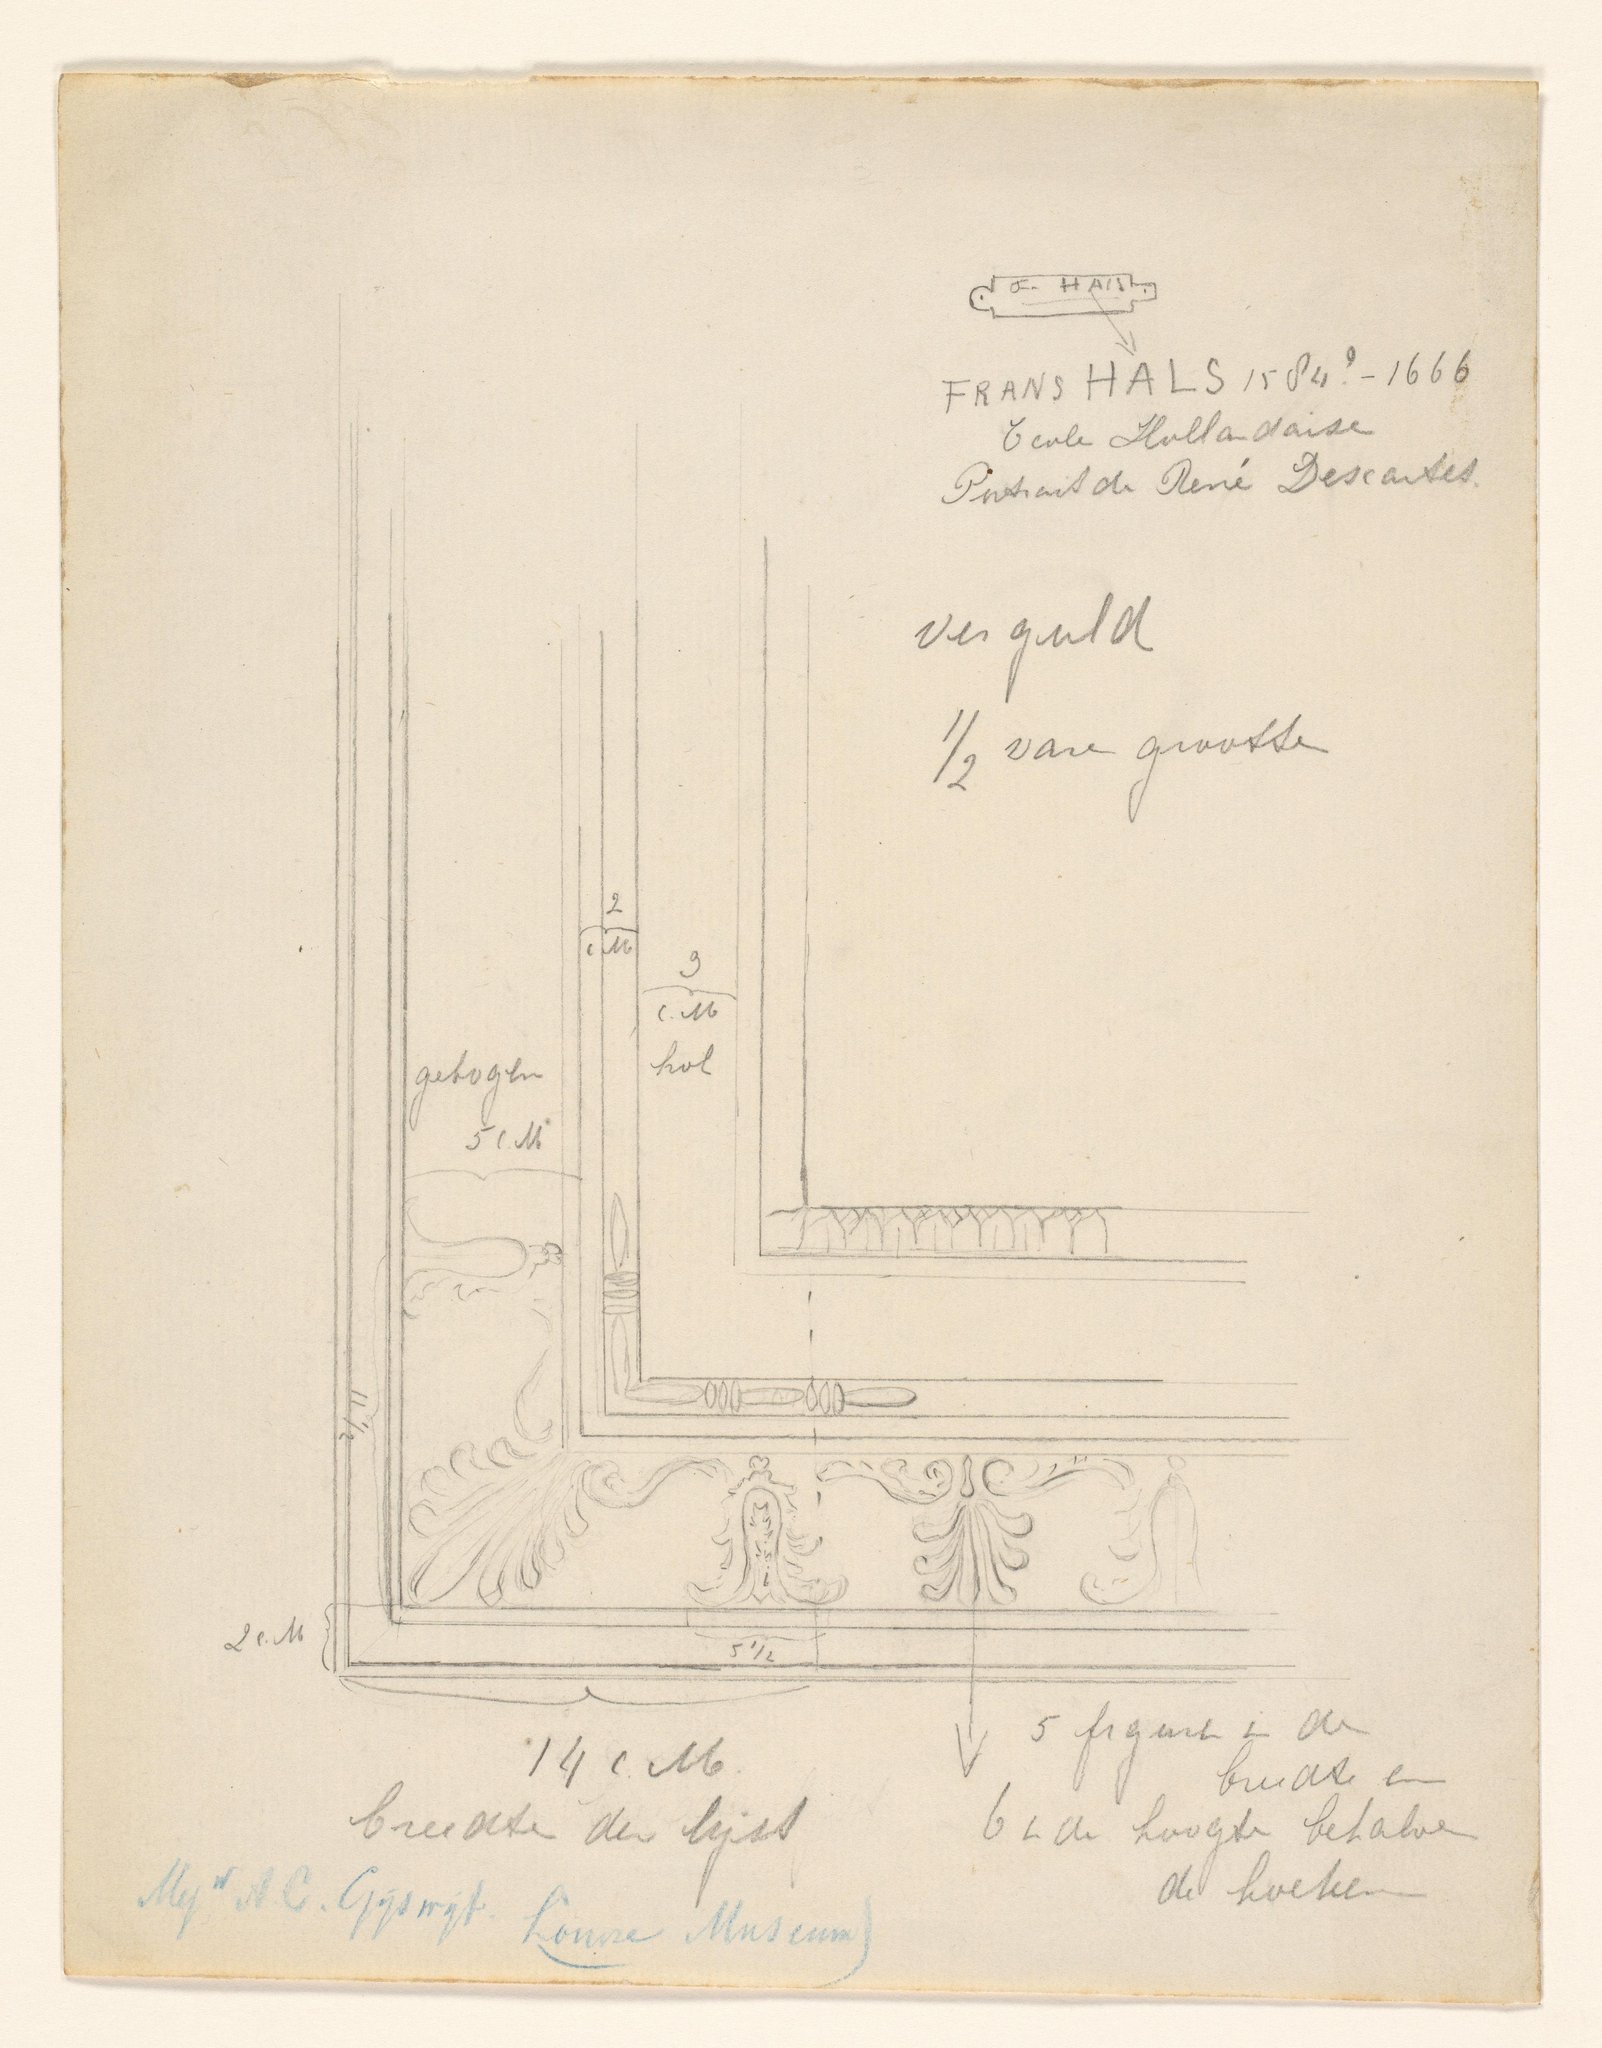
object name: drawing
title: Schets van de lijst van een portret van René Descartes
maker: august allebé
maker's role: draughtsman, print maker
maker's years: 1838-1927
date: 1848-1927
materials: paper, pencil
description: Schets van de lijst van het portret van René Descartes door Frans Hals, hangend in het Louvre.